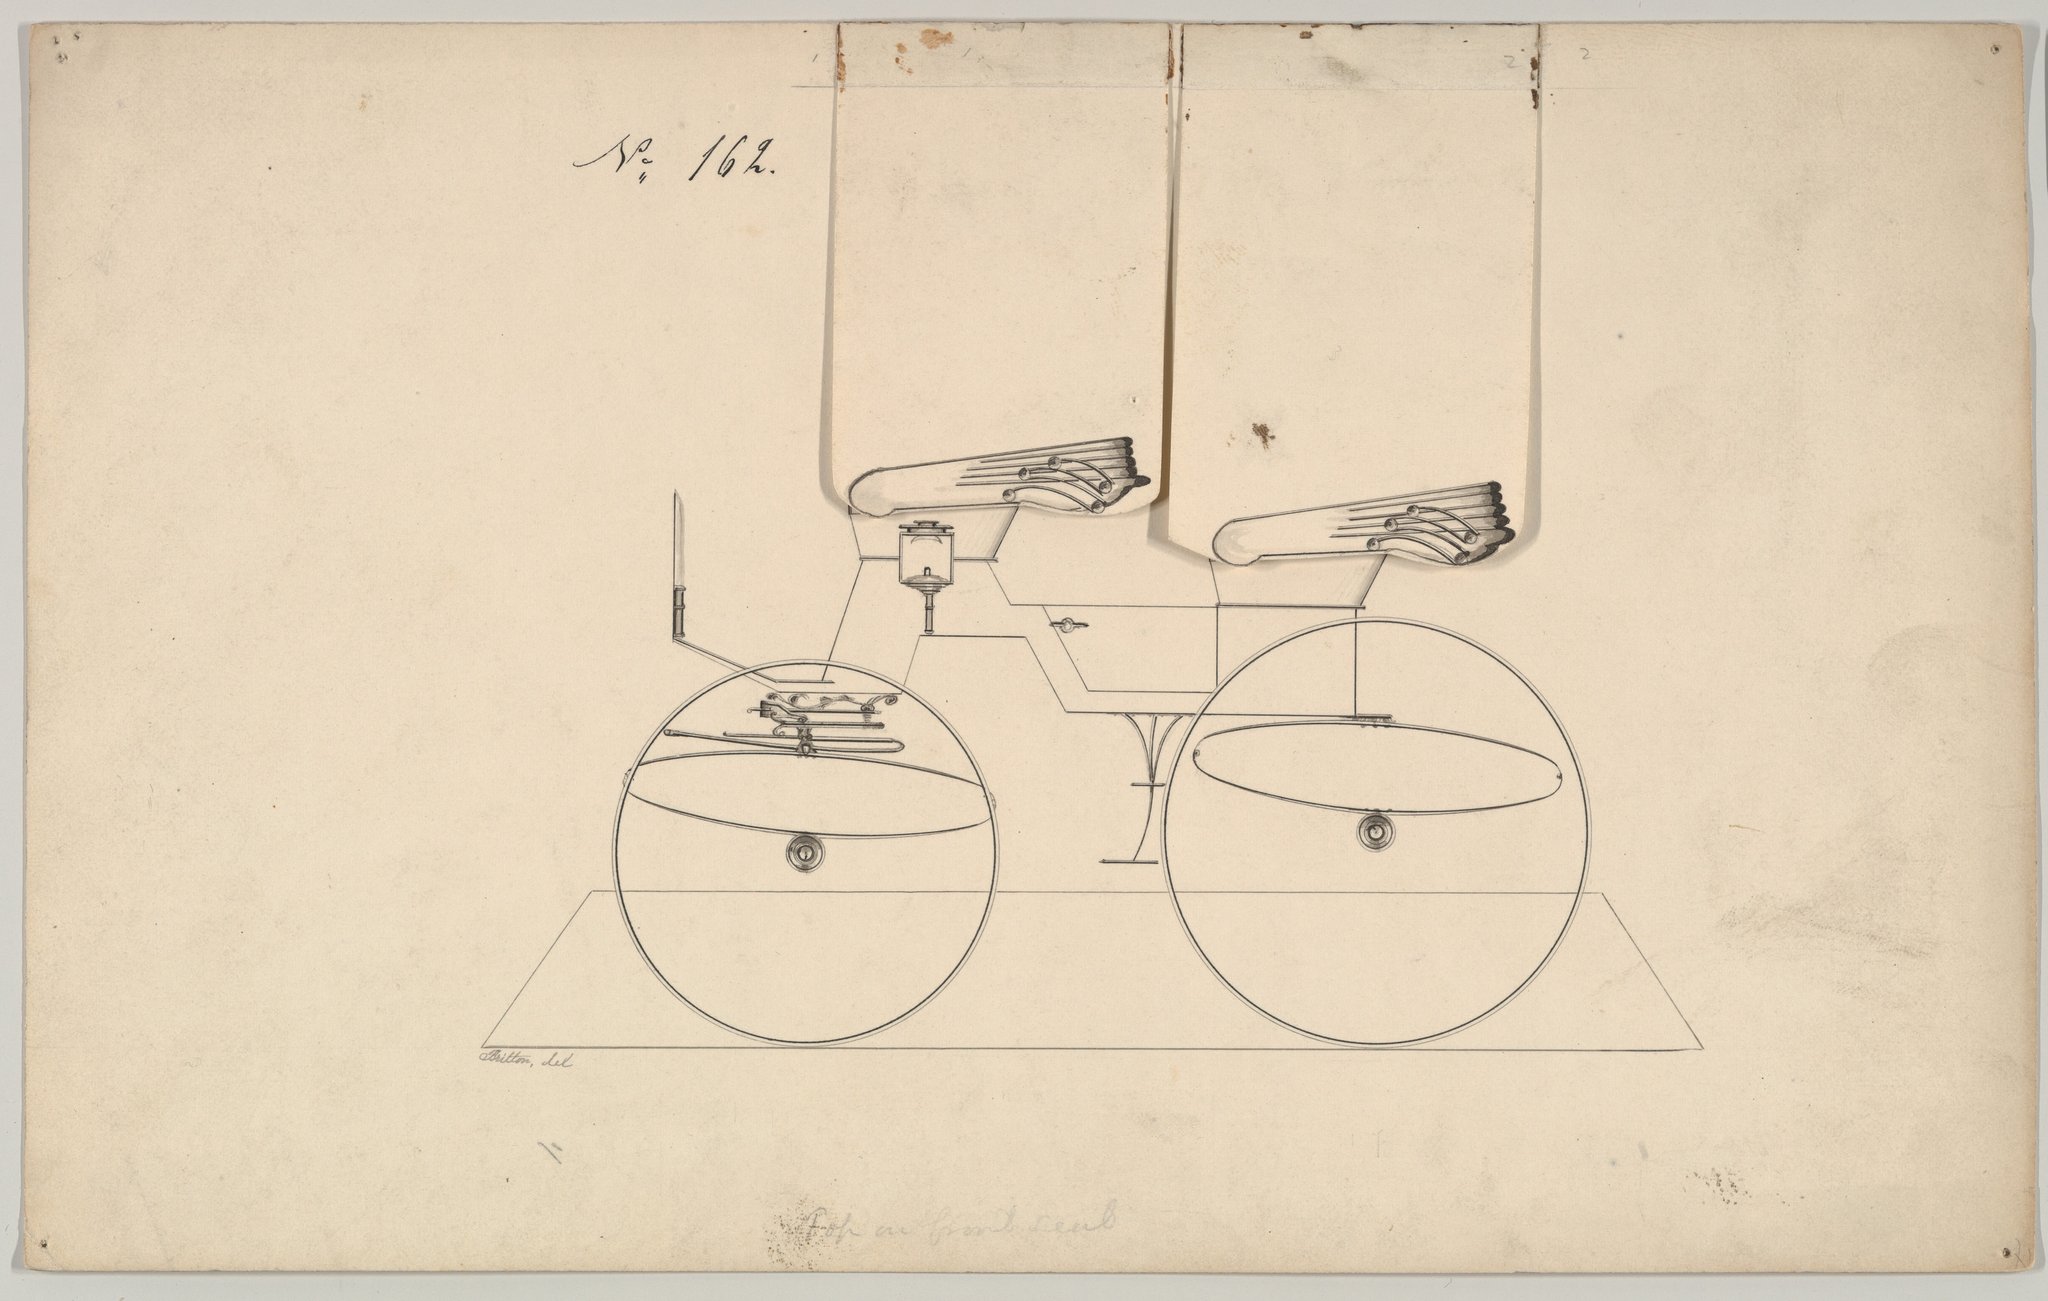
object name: drawing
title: Design for Phaeton, no. 162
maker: brewster & co.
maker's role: manufacturer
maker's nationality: american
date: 1850-1874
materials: ink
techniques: pen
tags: carriages